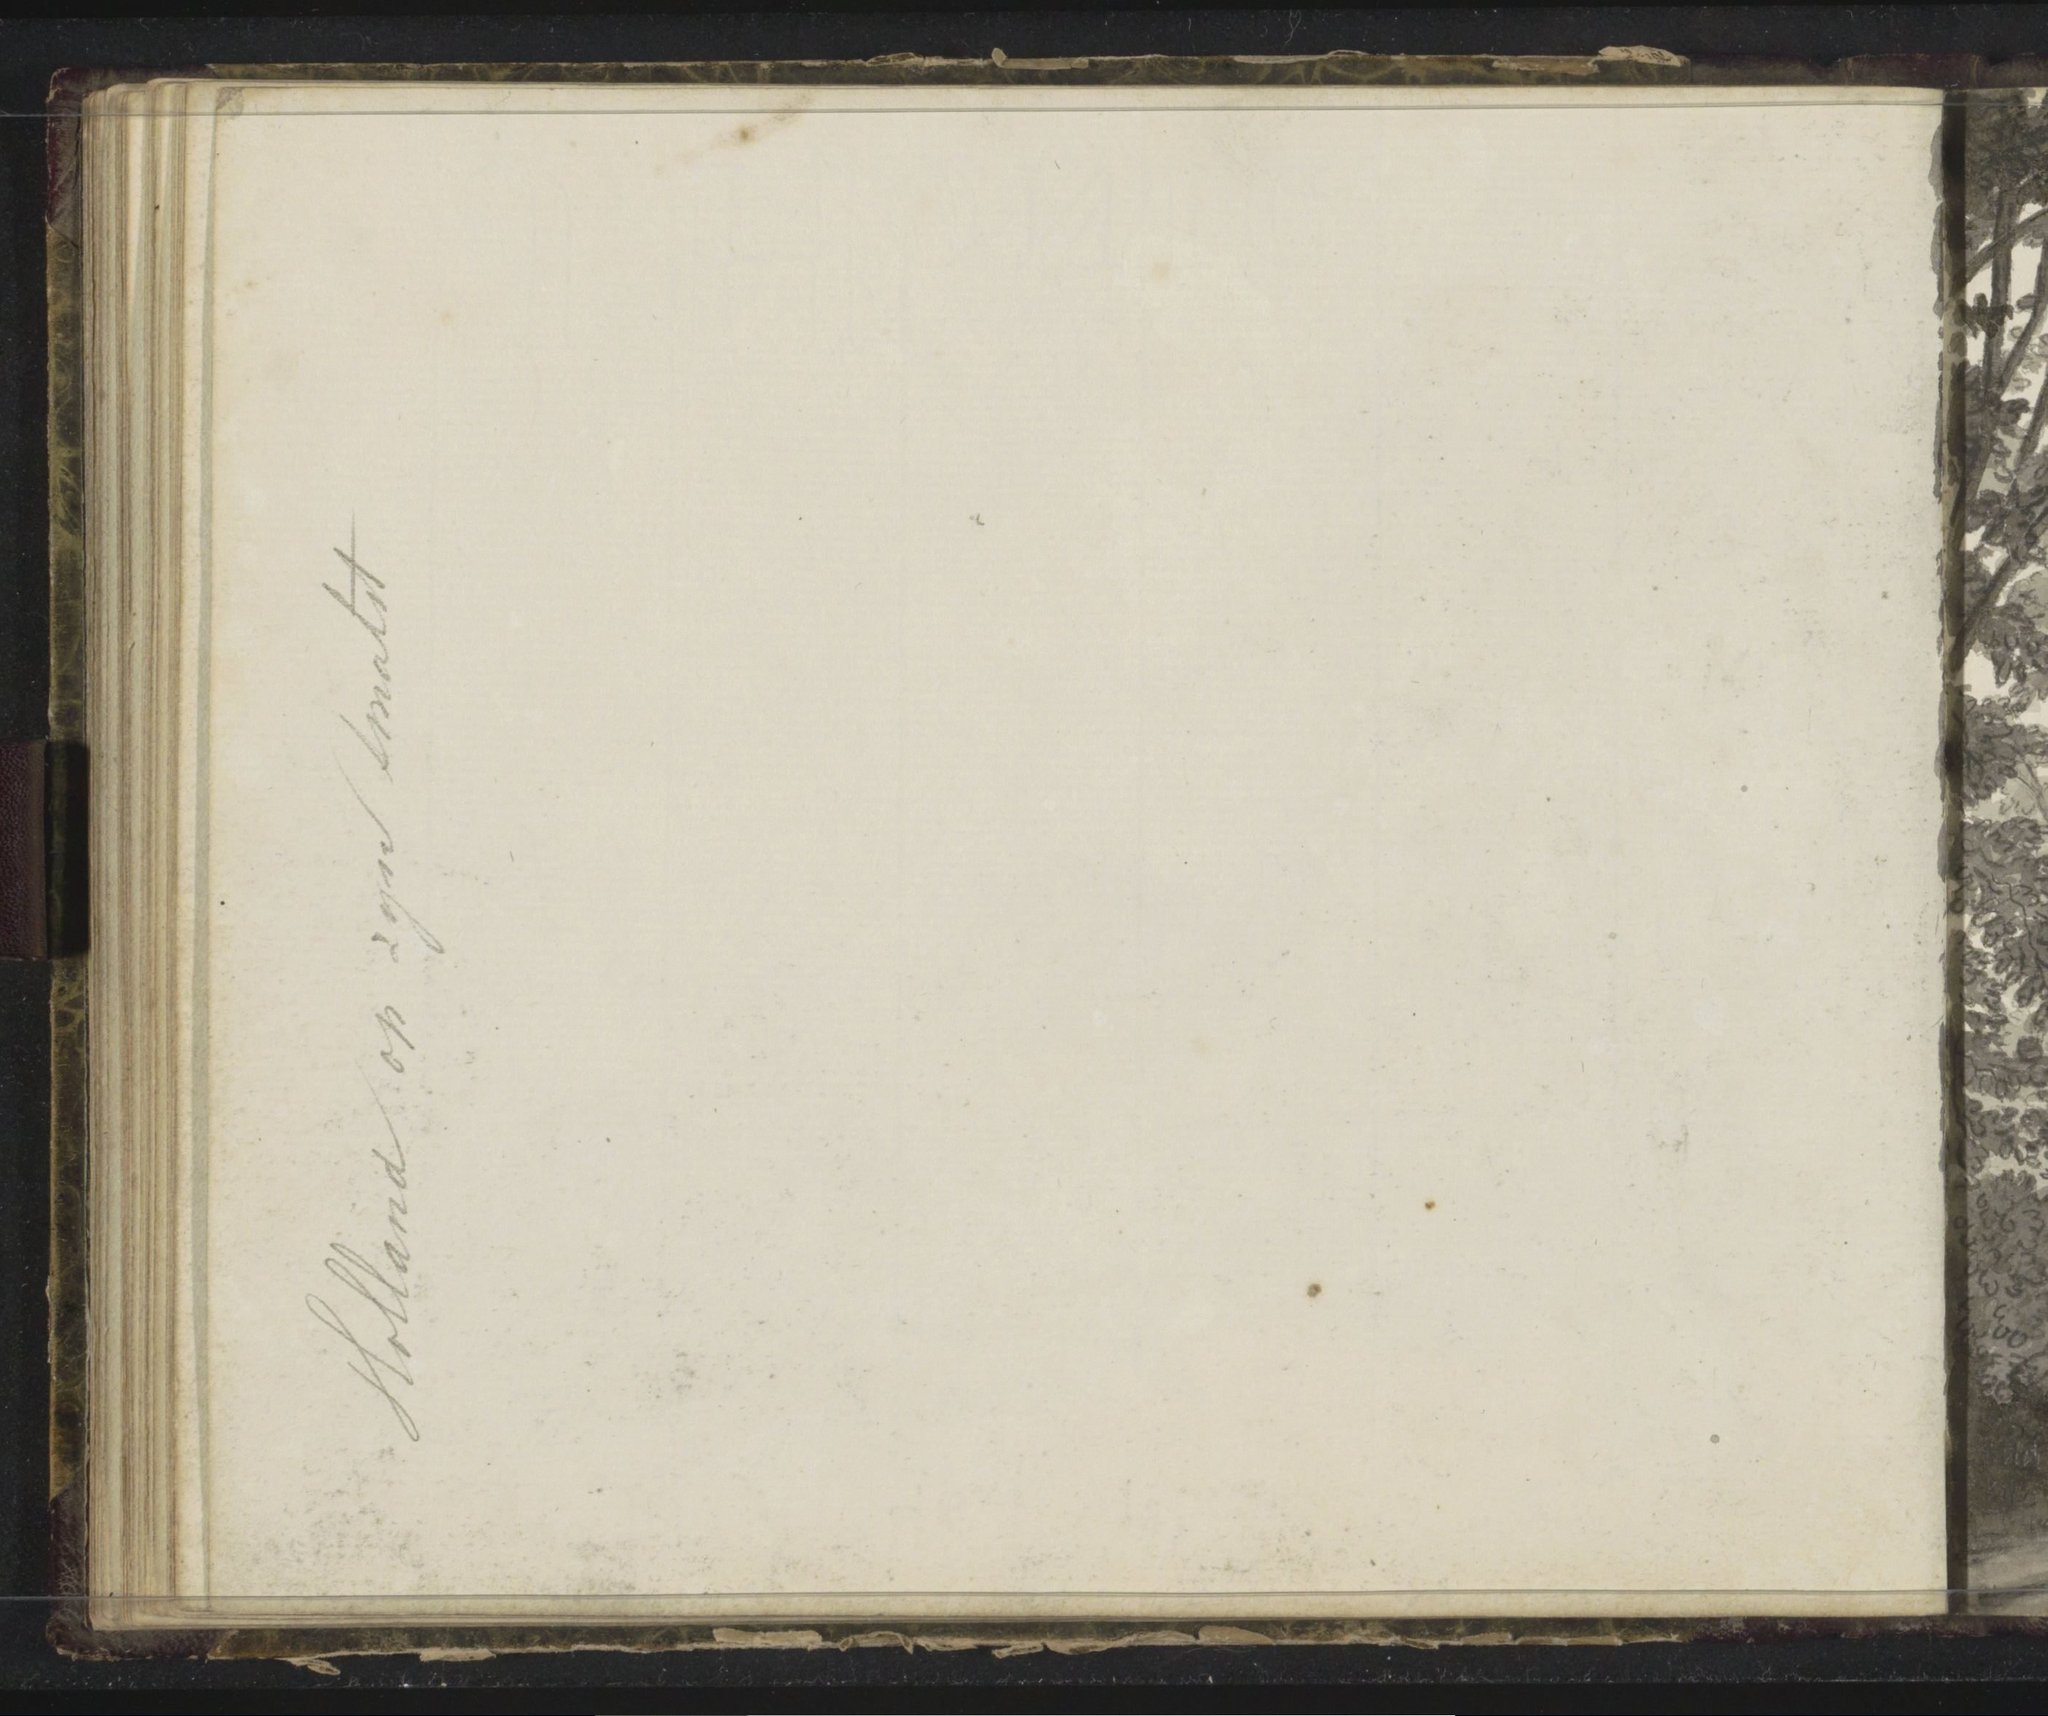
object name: sketchbook leaf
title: Notitie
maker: hendrik abraham klinkhamer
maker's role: draughtsman, painter, print maker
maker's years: 1810-1872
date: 1820-1872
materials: paper, pencil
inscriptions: annotation: ‘Holland op zijn smalst’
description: Blad 27 verso uit een schetsboek met 39 bladen.